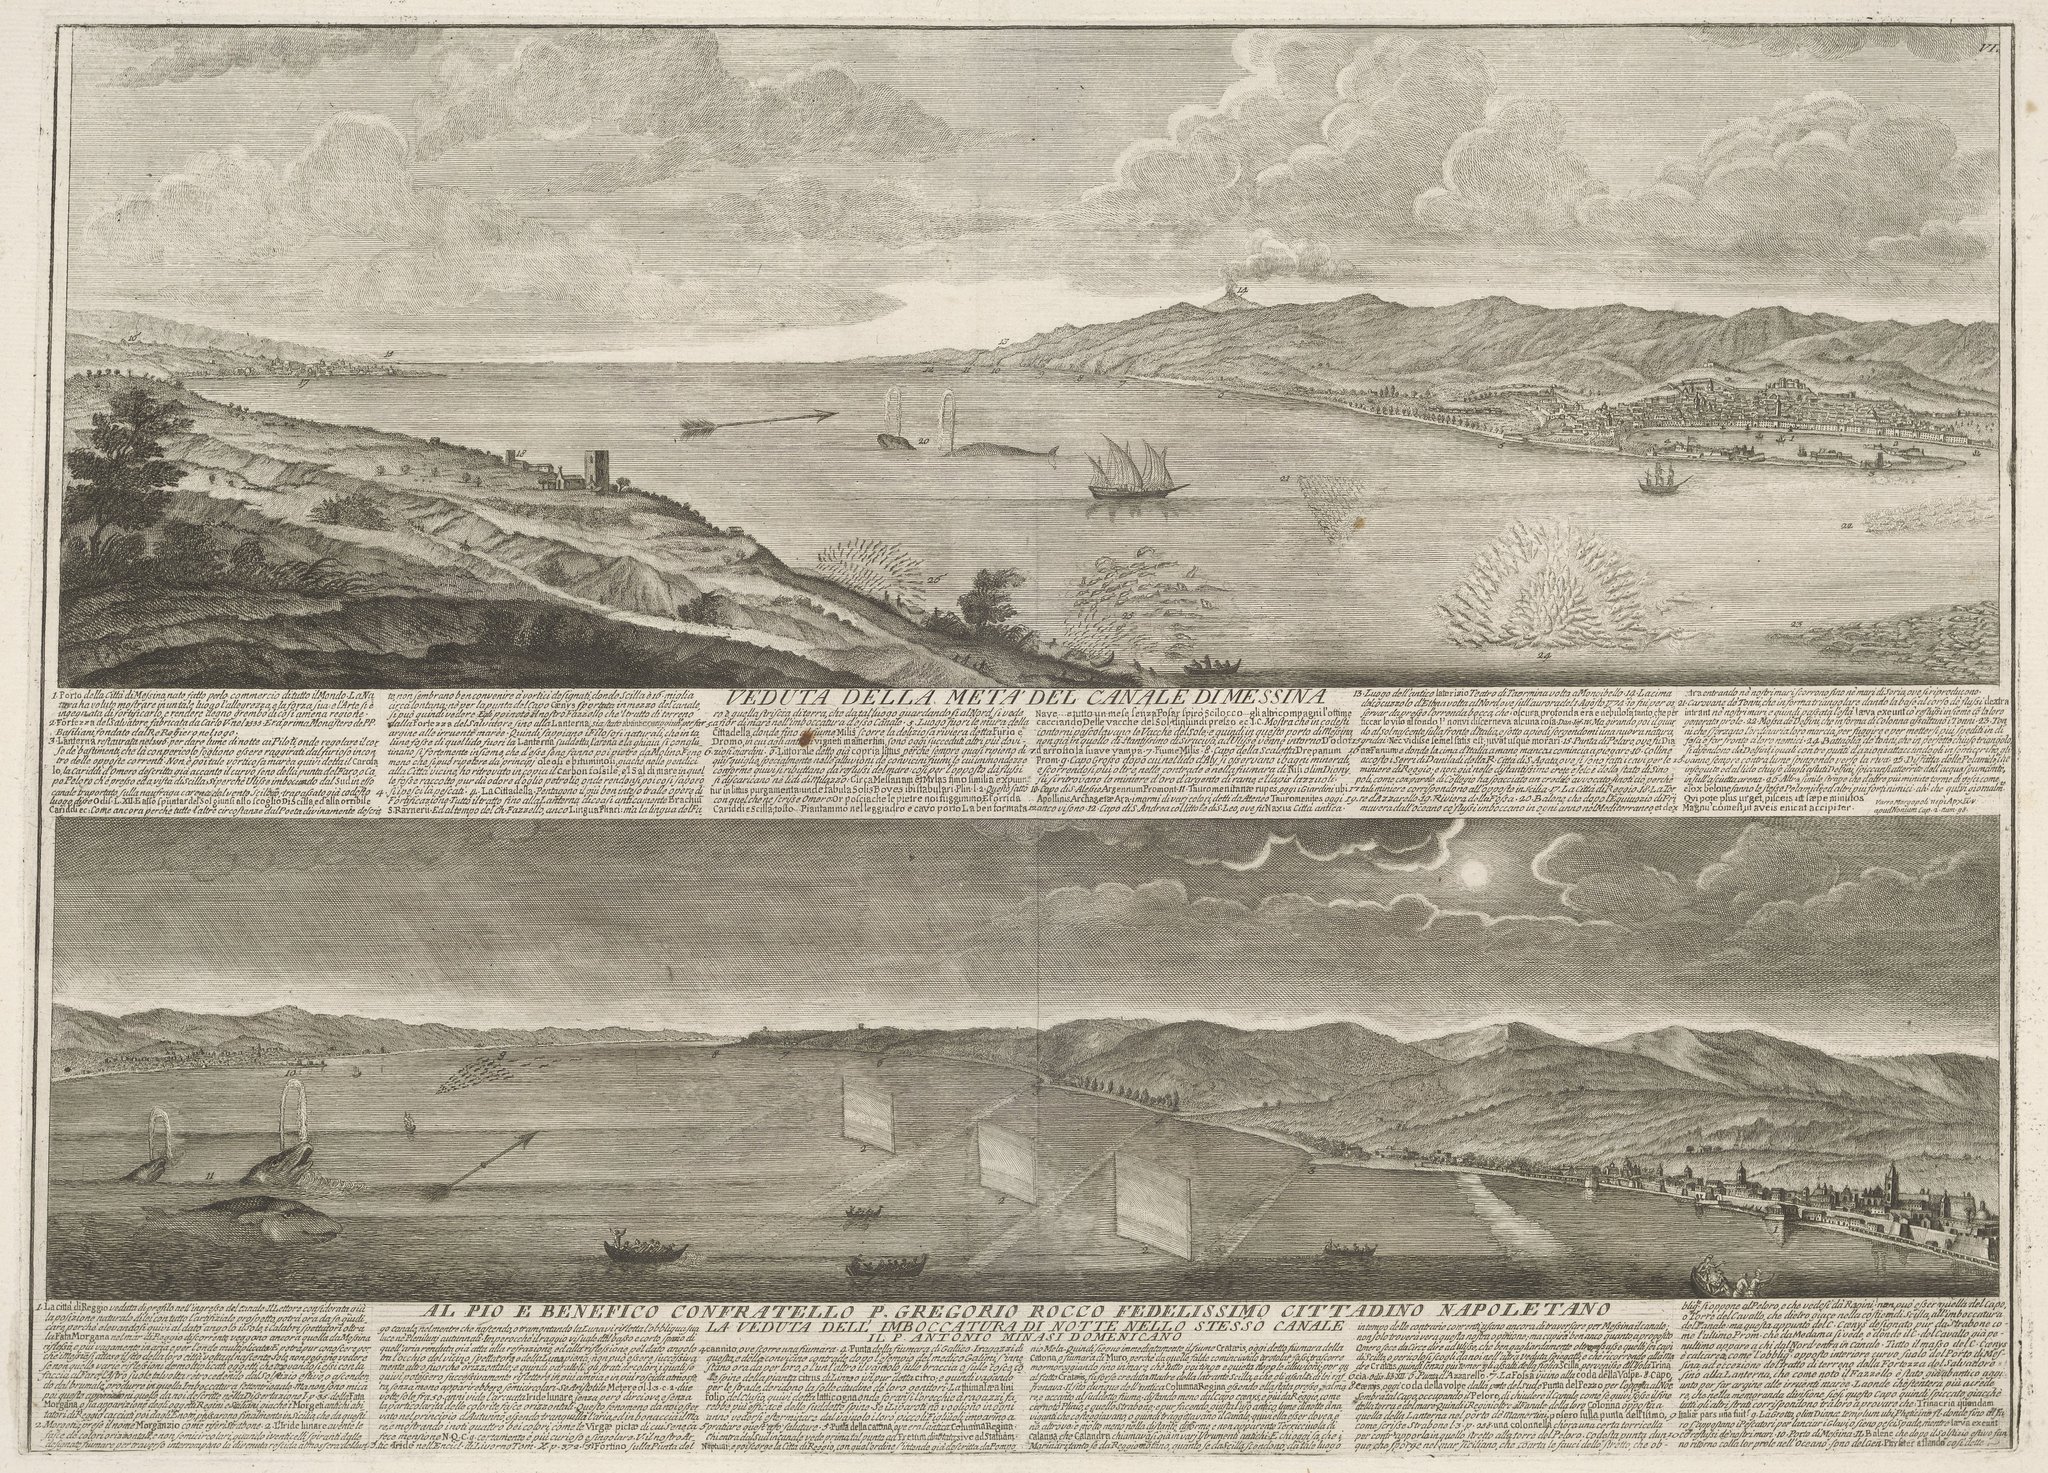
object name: print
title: Het Kanaal van Messina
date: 1700-1782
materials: paper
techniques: etching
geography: italy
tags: landscapes, canal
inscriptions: collector's mark: Lugt 2228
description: Boven: gezicht op het Kanaal van Messina, met verklarende lijst met nummers in ondermarge. Onder: gezicht op het Kanaal van Messina, met verklarende lijst met nummers in ondermarge. Genummerd rechtsboven: VI.